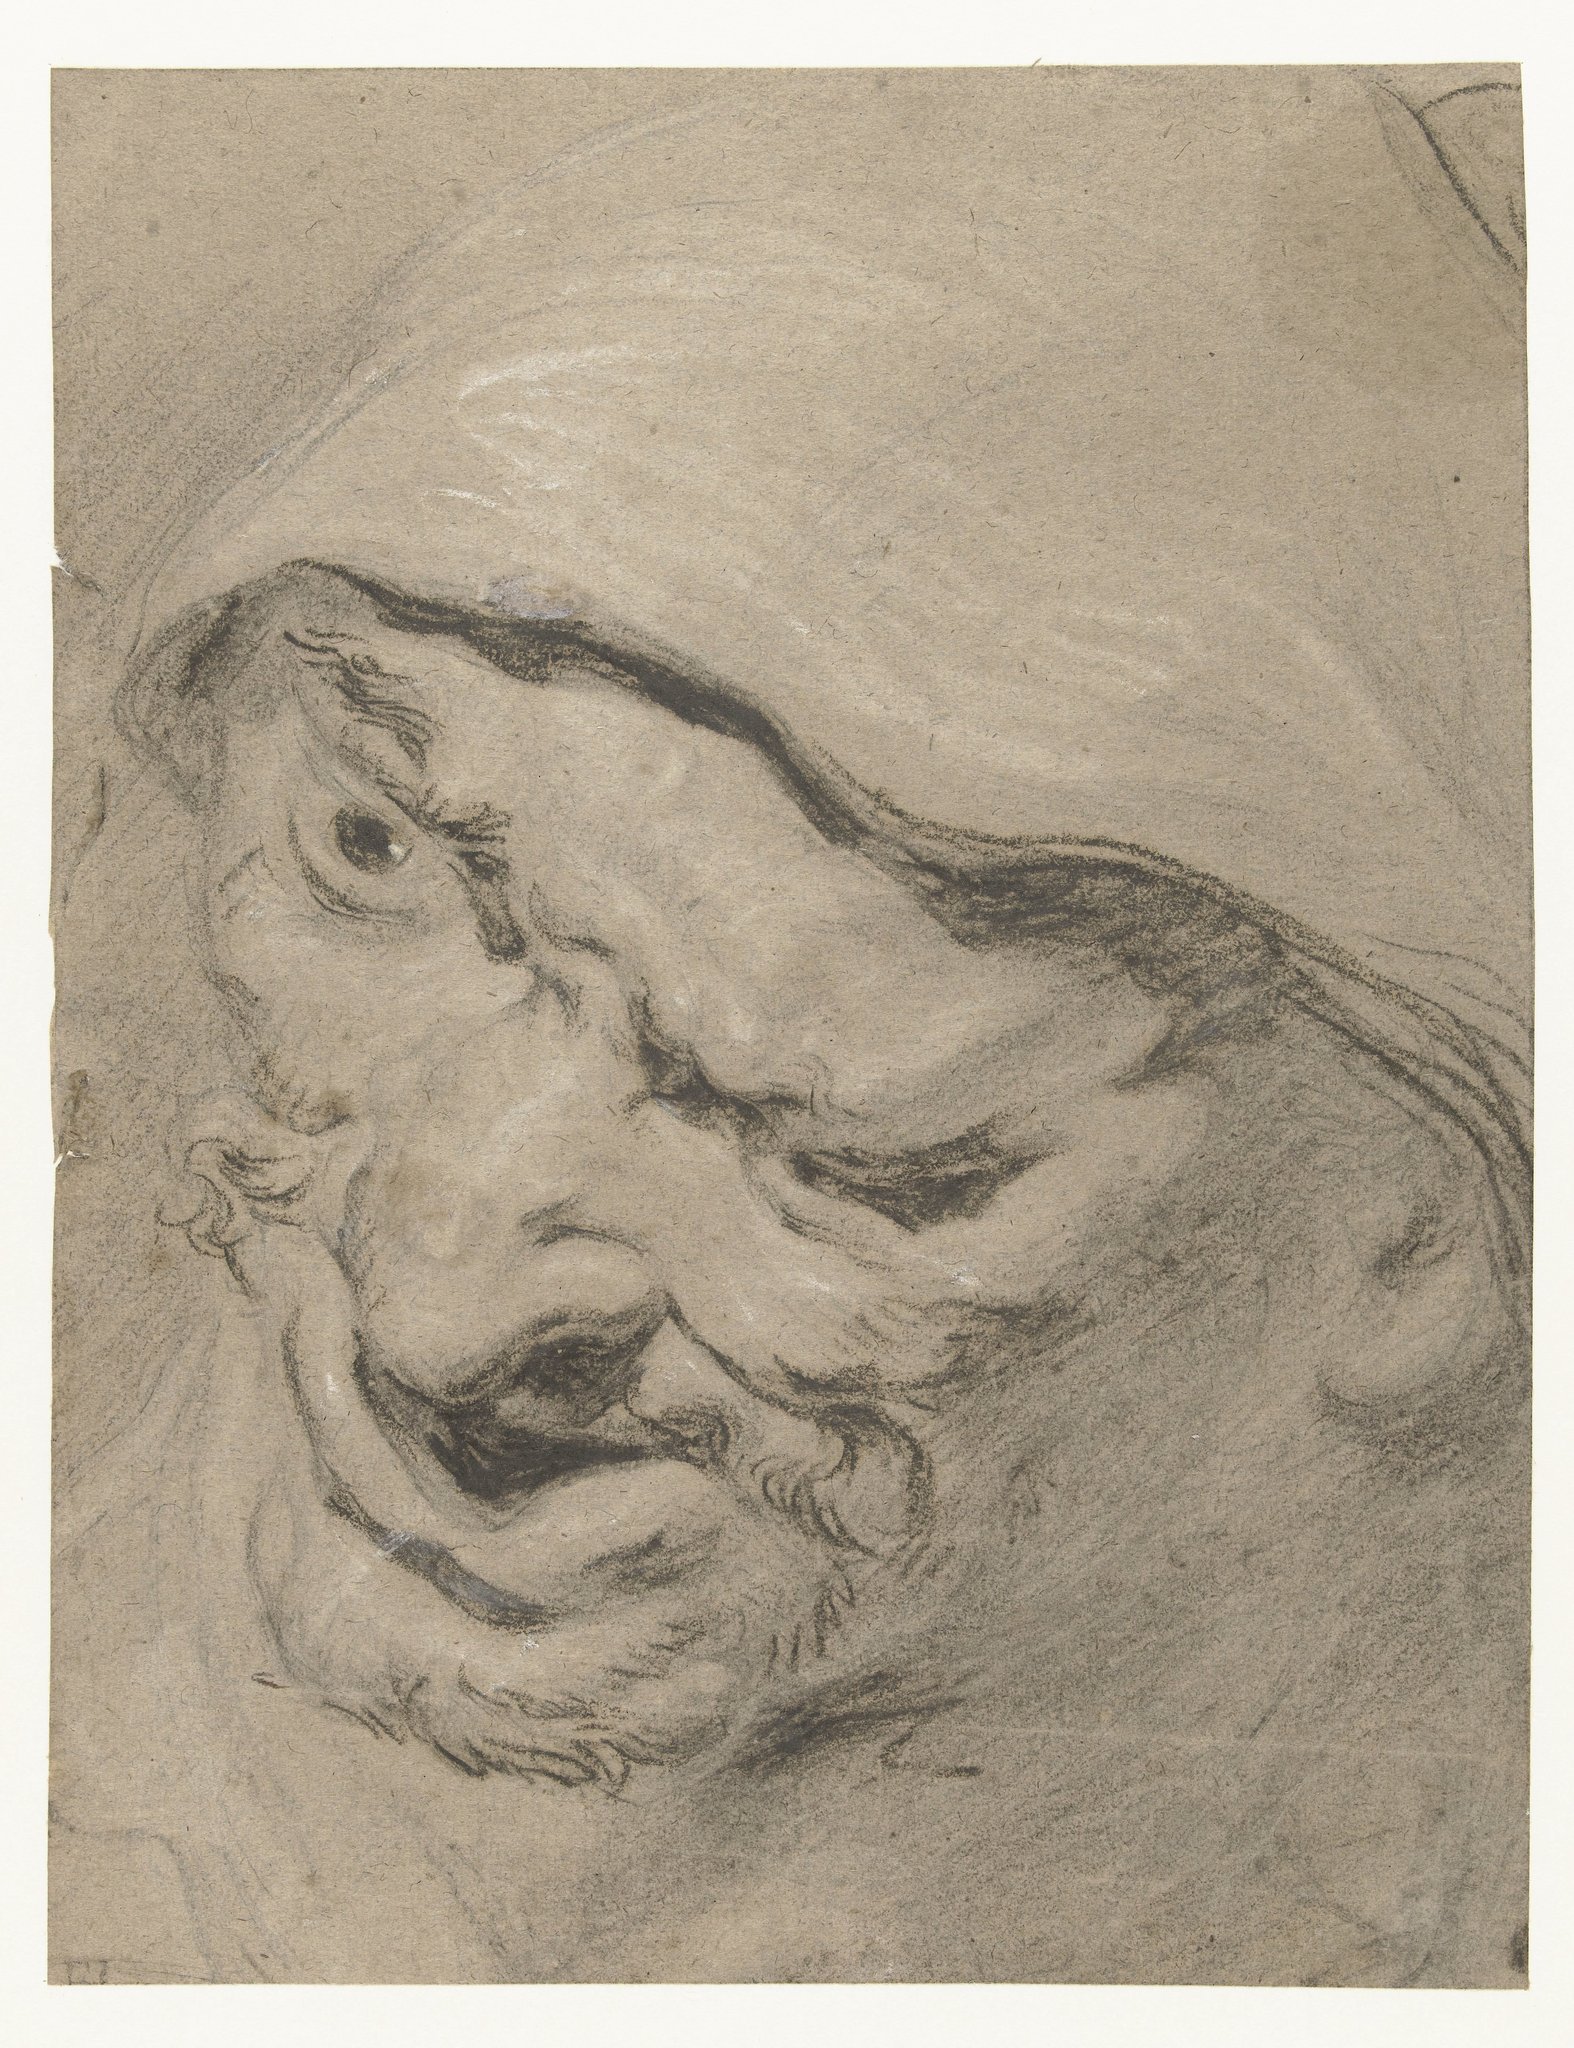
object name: drawing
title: Manskop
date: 1587-1640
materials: chalk, paper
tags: head (human), male sex; man